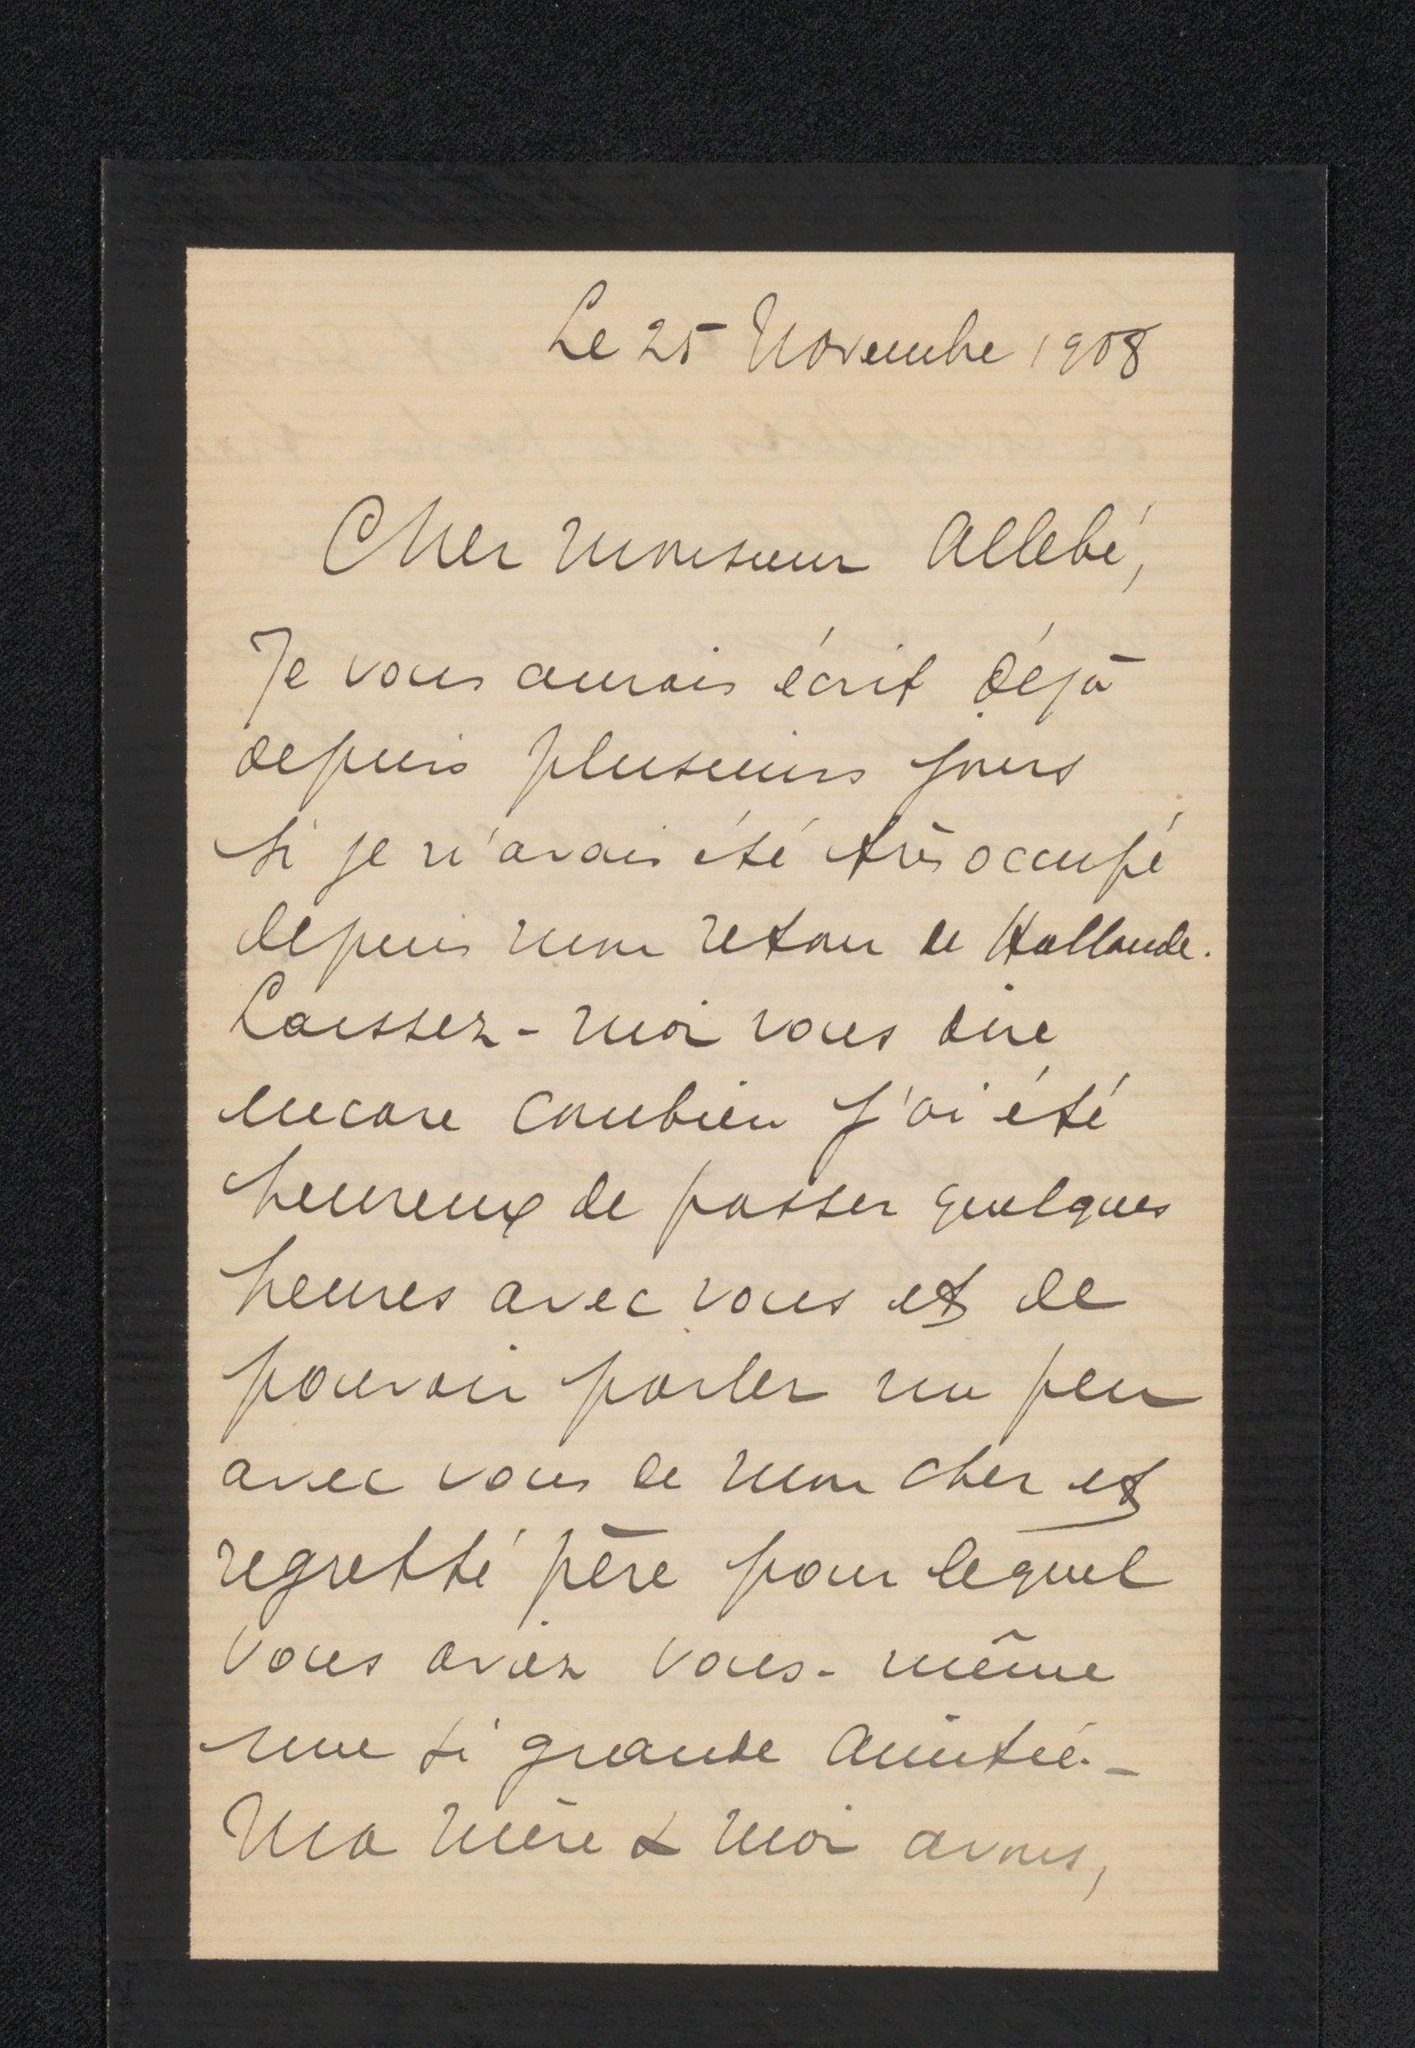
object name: letter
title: Brief aan August Allebé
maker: e. de haas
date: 1908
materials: ink, paper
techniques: pen, writing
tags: august allebé, painter, draughtsman, johannes hubertus leonardus de haas, den bosch, amsterdam, print maker, antoon derkinderen, abraham kuyper, drawing, travelling; tourism, netherlands